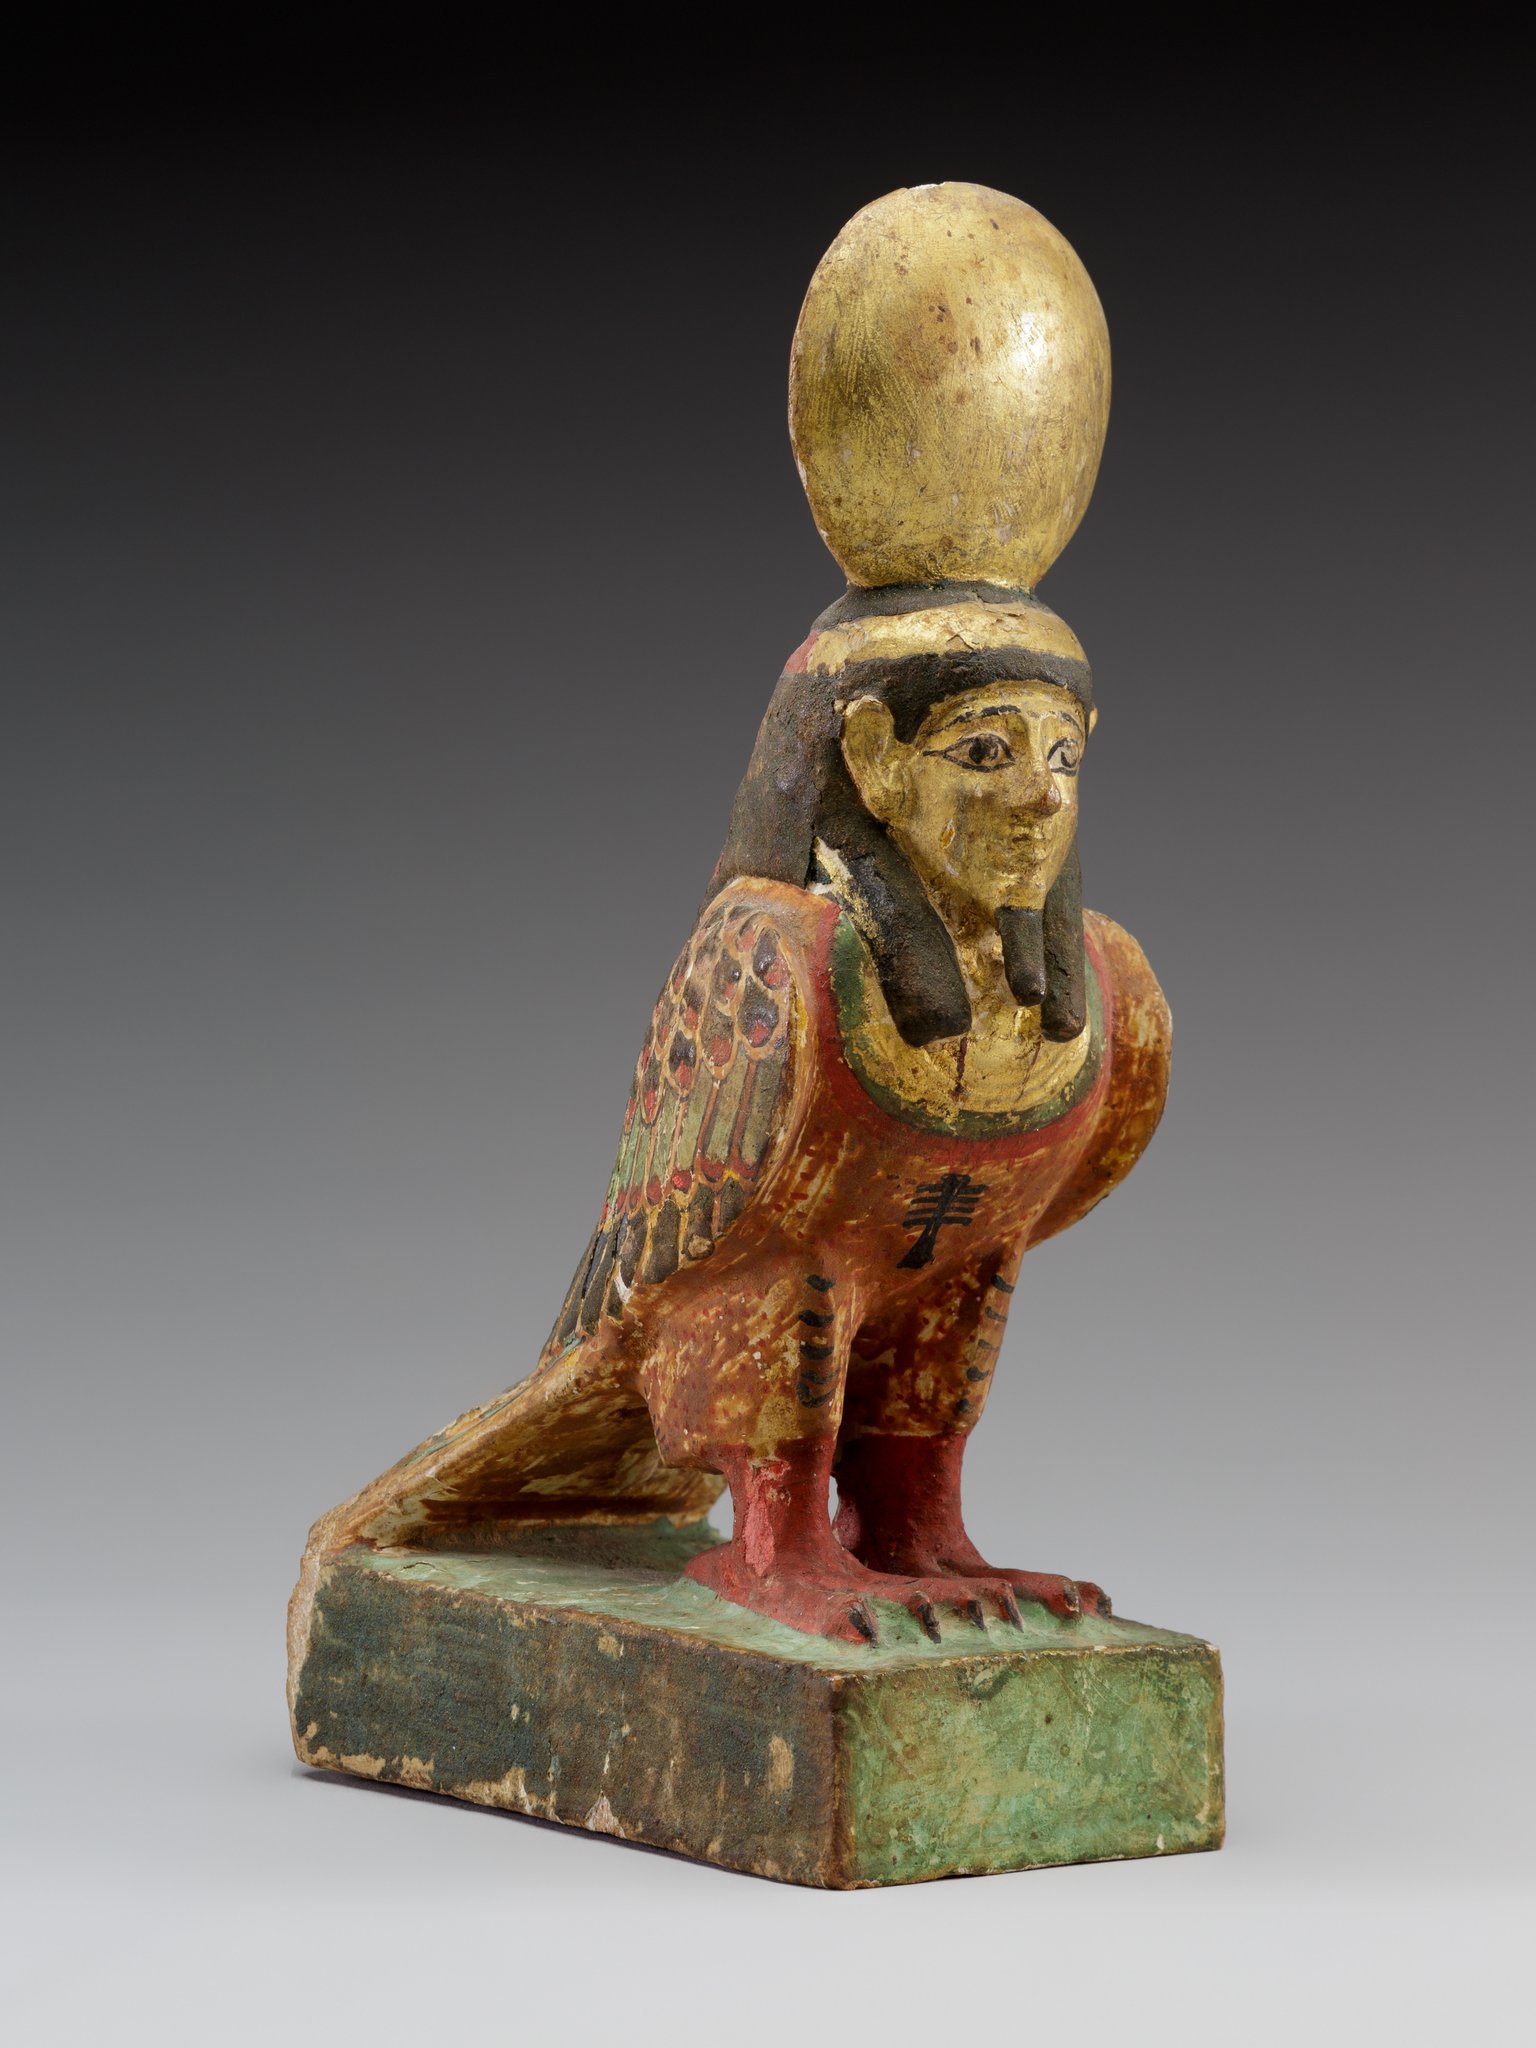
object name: statuette, ba bird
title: Ba-bird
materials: gold leaf, paint, wood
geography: egypt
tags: birds